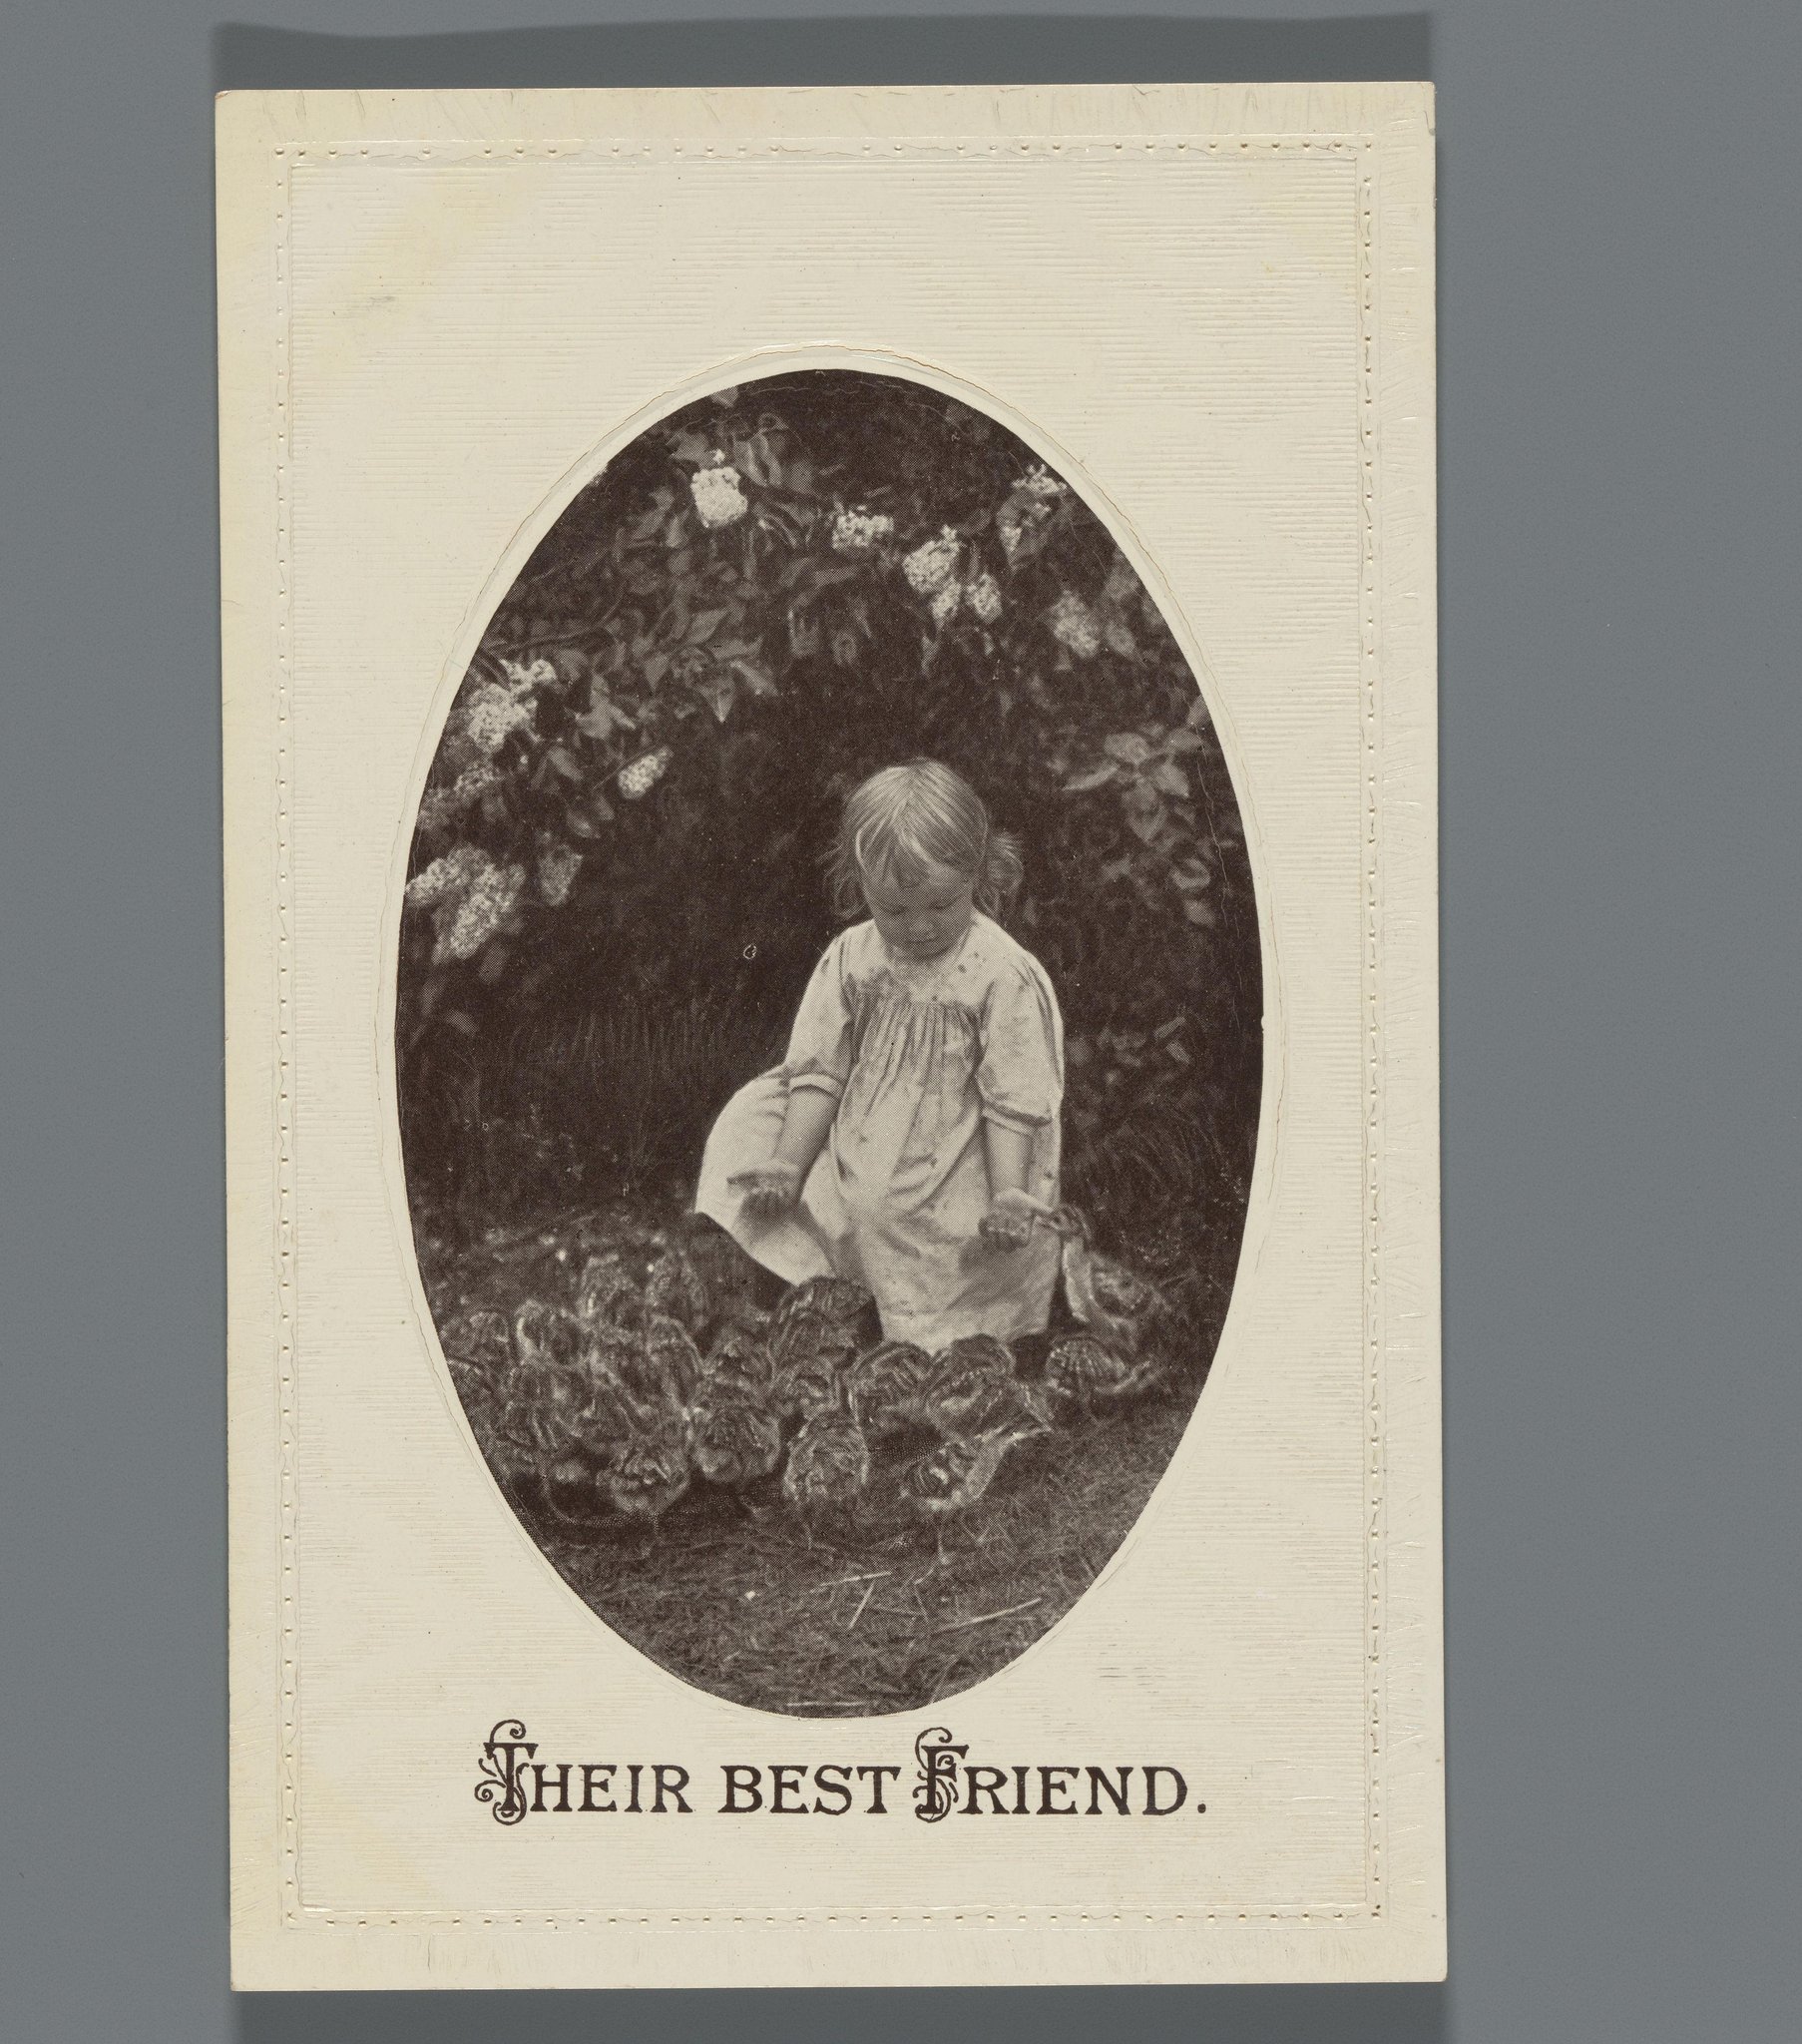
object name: ansichtkaart, prentbriefkaart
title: Their best friend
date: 1906-1909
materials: paper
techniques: autotype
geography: london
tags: child, water-birds: duck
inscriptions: inscription: ‘No. 62. Printed in Saxony.’